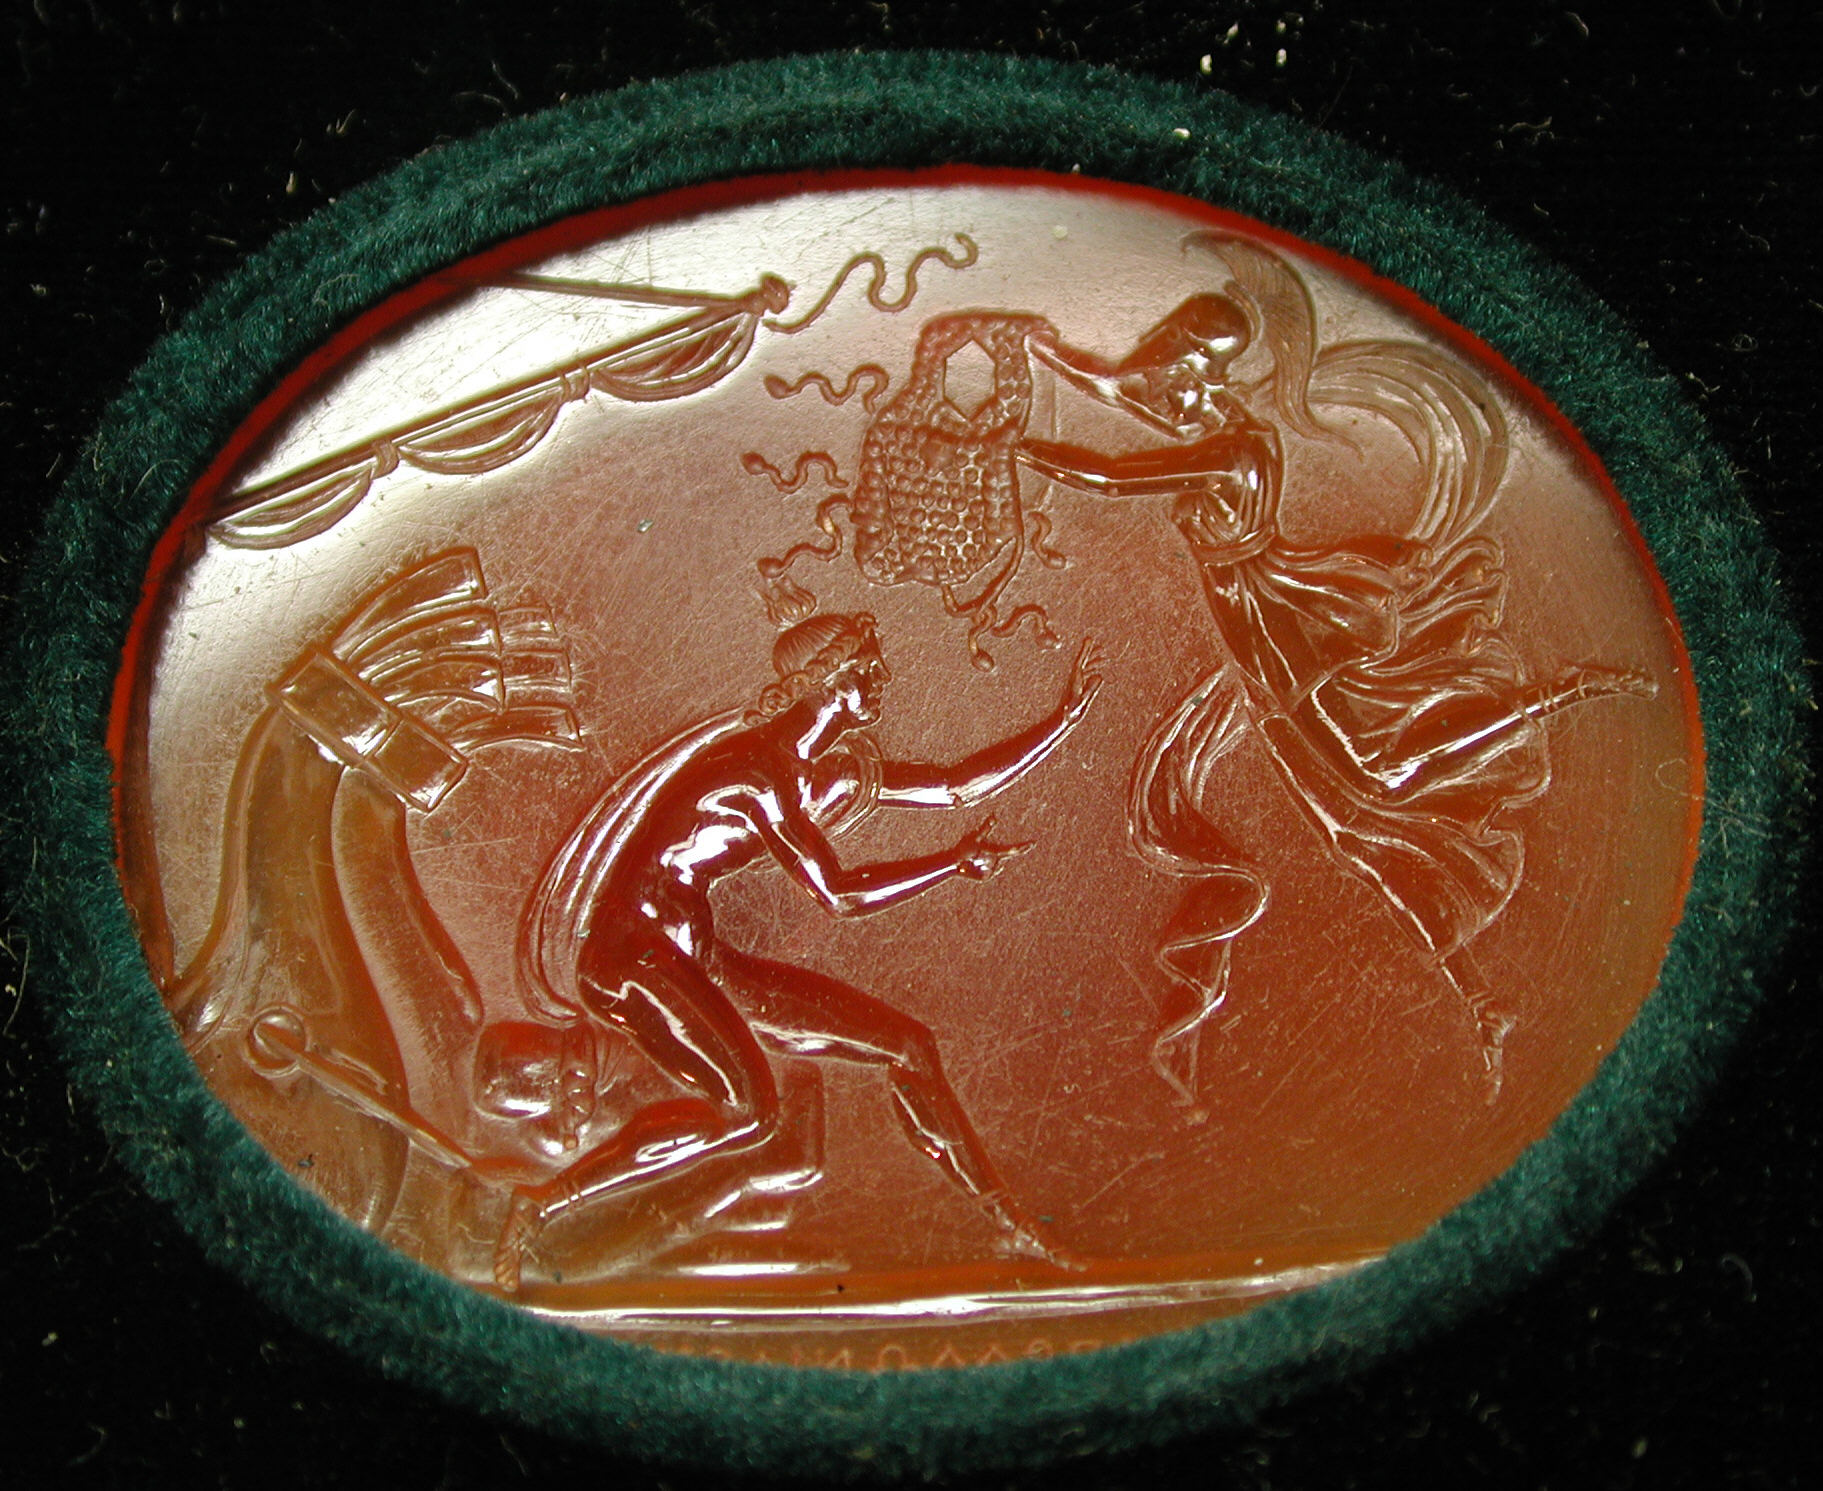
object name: intaglio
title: Minerva throwing her aegis over Achilles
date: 1801-1833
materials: gemstone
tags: achilles,minerva